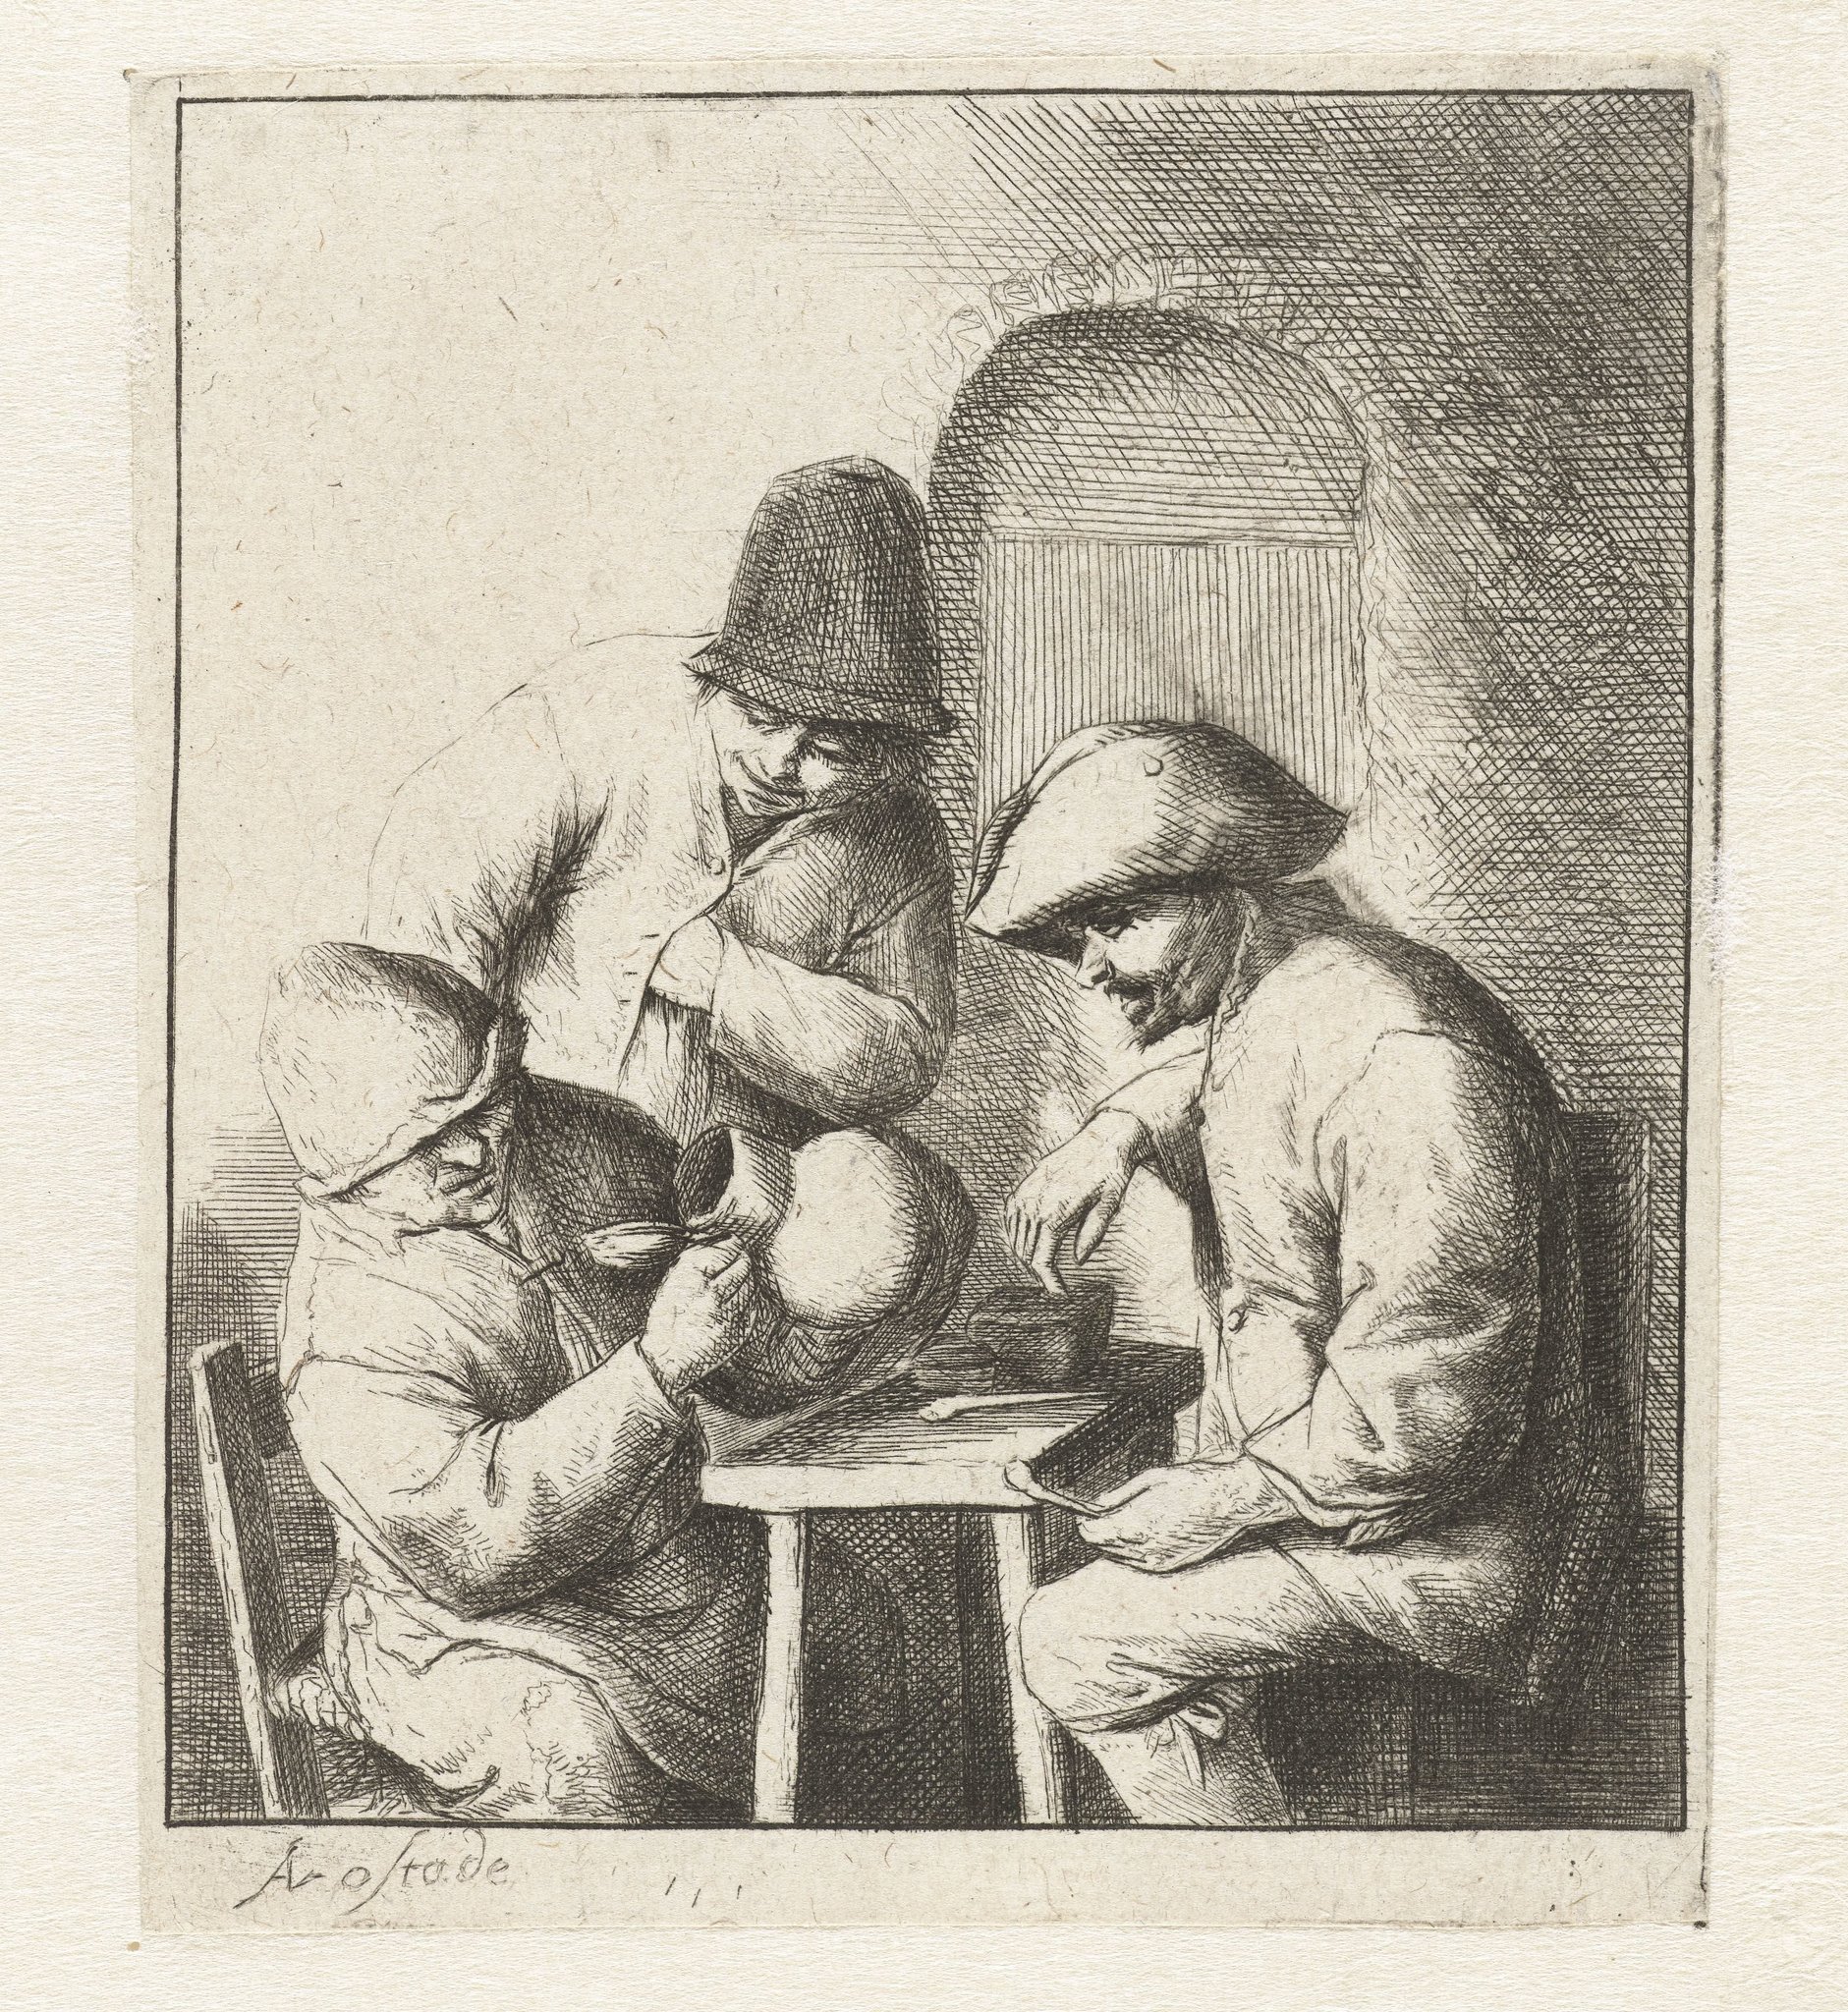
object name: print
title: De ledige kruik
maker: adriaen van ostade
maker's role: draughtsman, painter, print maker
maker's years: 1610-1685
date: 1651-1655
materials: paper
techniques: etching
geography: haarlem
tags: inn, coffee-house, public house, etc., drinking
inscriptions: collector's mark: Lugt 2610, collector's mark: Lugt 2228a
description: Enkele gebaren van de mannen in deze voorstelling dragen een negatieve betekenis. De man die in de lege kruik kijkt is een kannekijker ofwel een dronkaard. Het gebaar van de staande man achter hem, met zijn hand verstopt achter zijn hemd, werd in verband gebracht met luiheid.